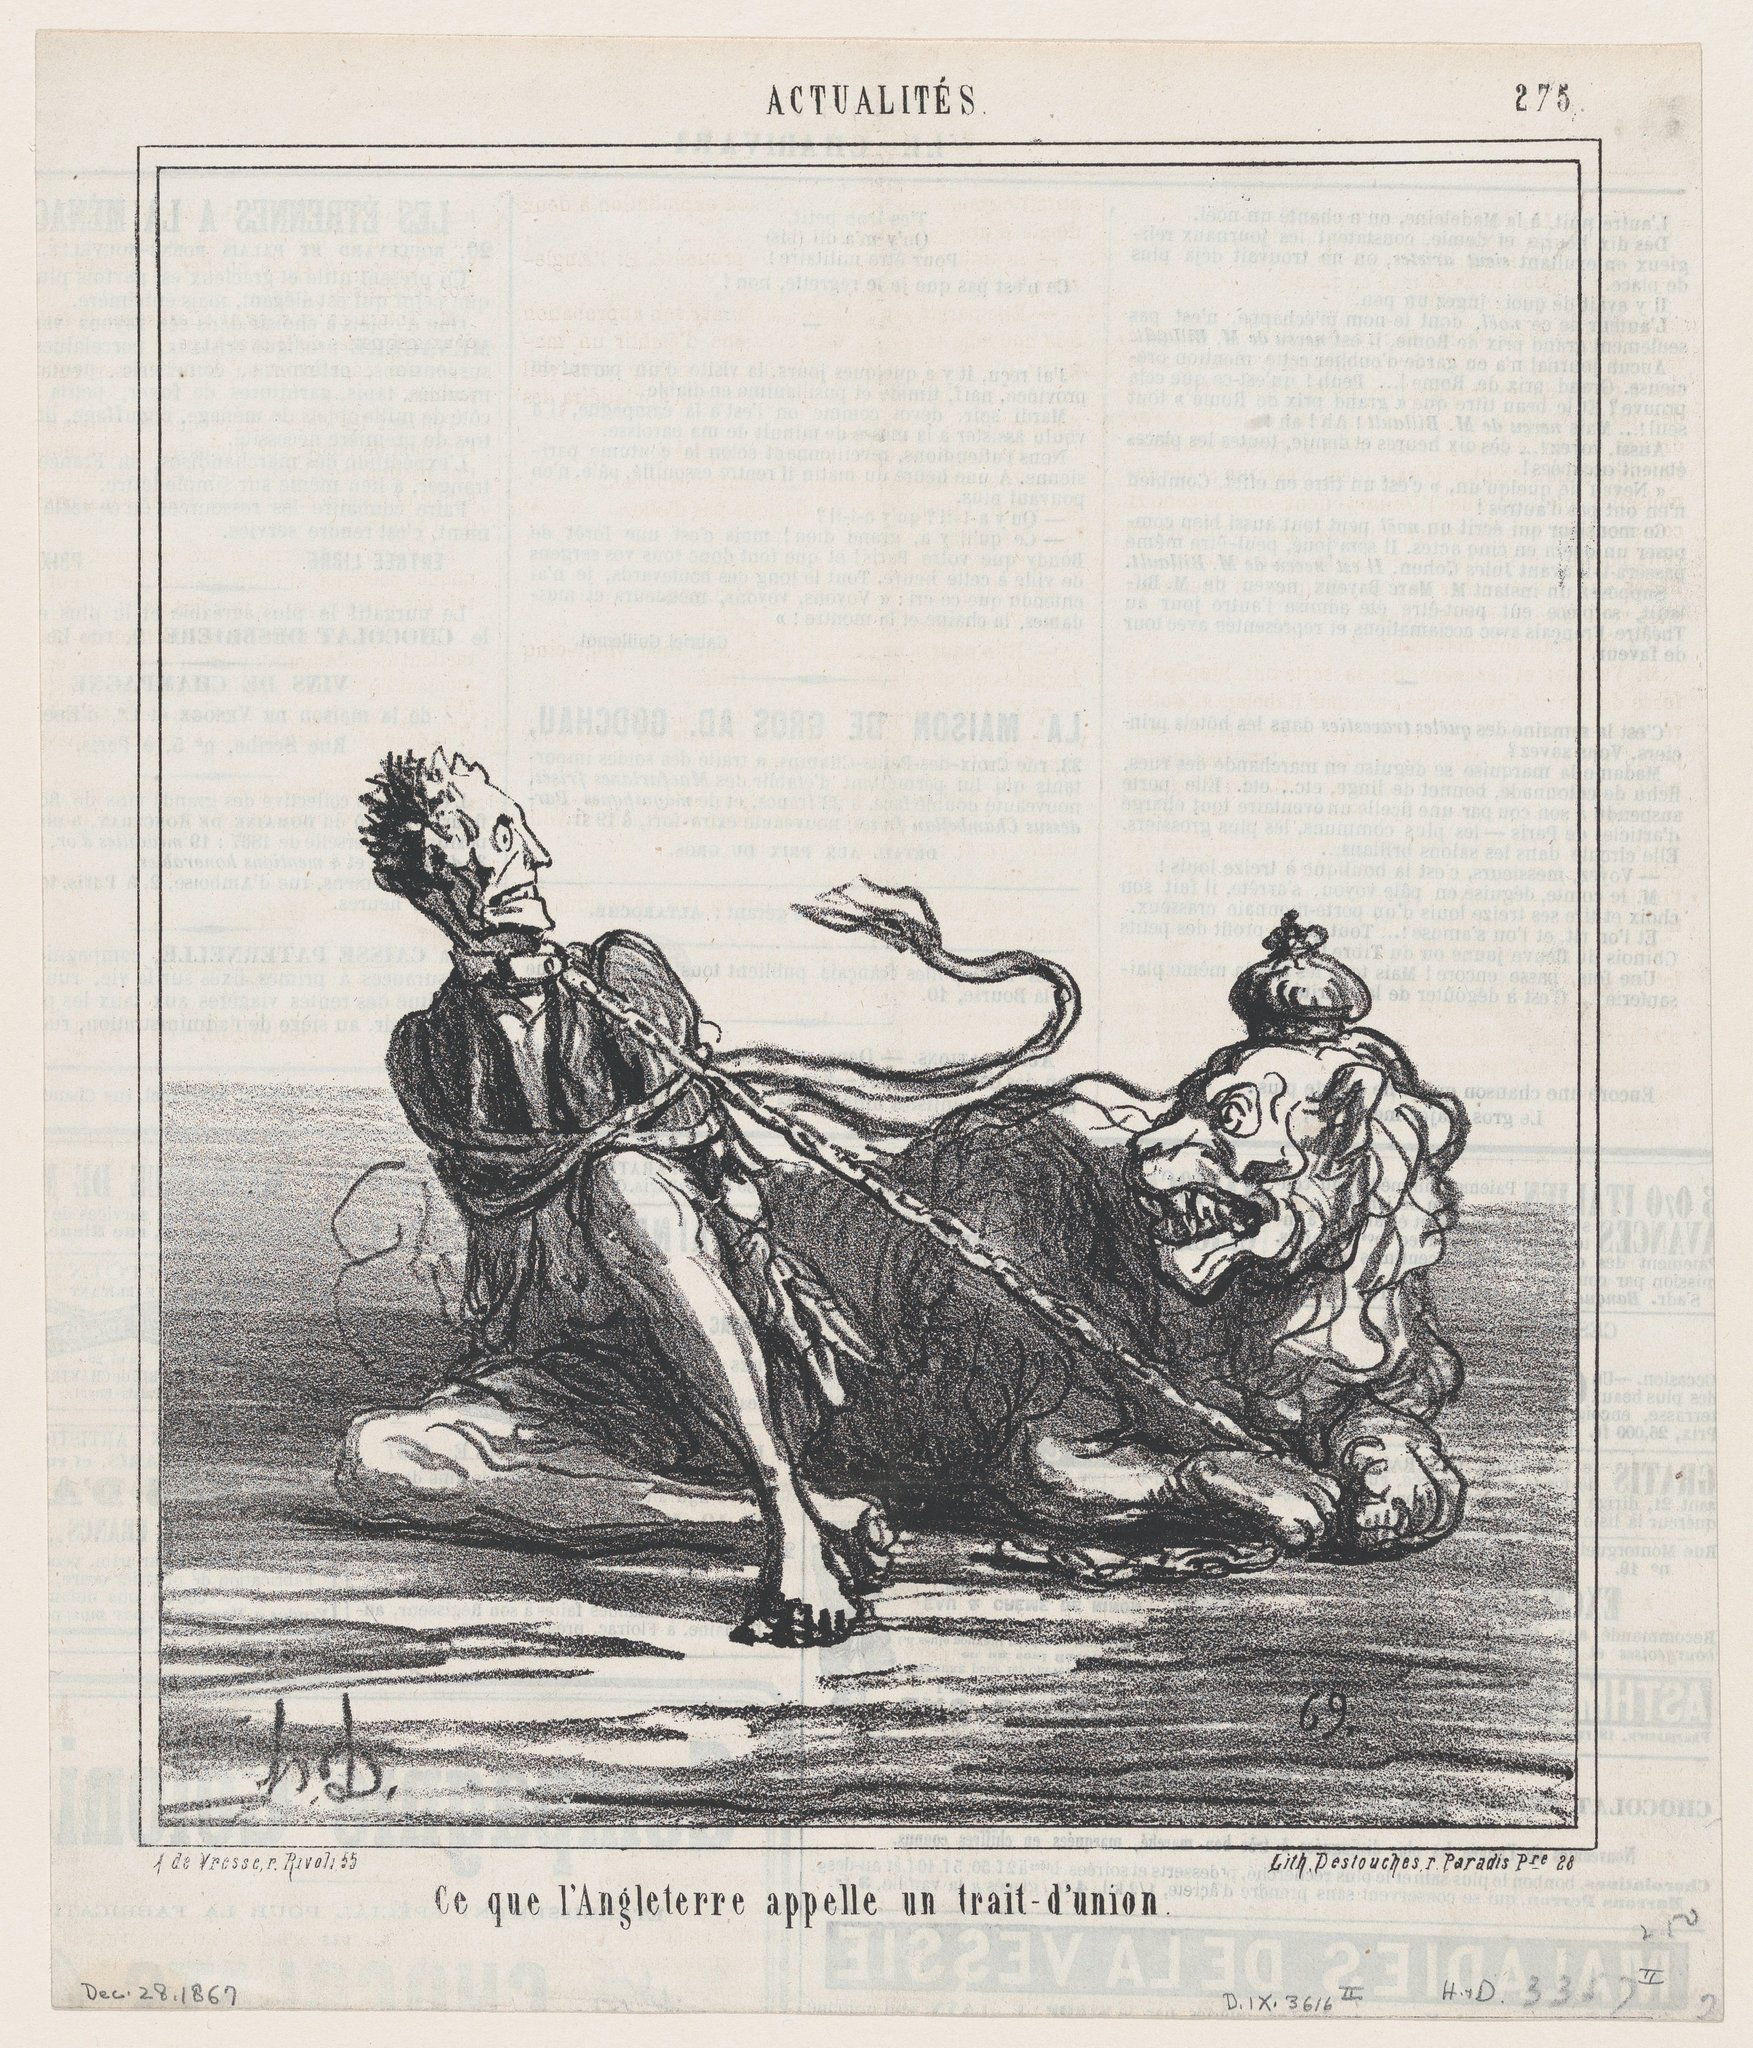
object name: print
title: This is what England calls a joint union, from "News of the Day"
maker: honoré daumier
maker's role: artist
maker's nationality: french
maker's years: 1808-1879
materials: paper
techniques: lithograph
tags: satire,fear,men,lions